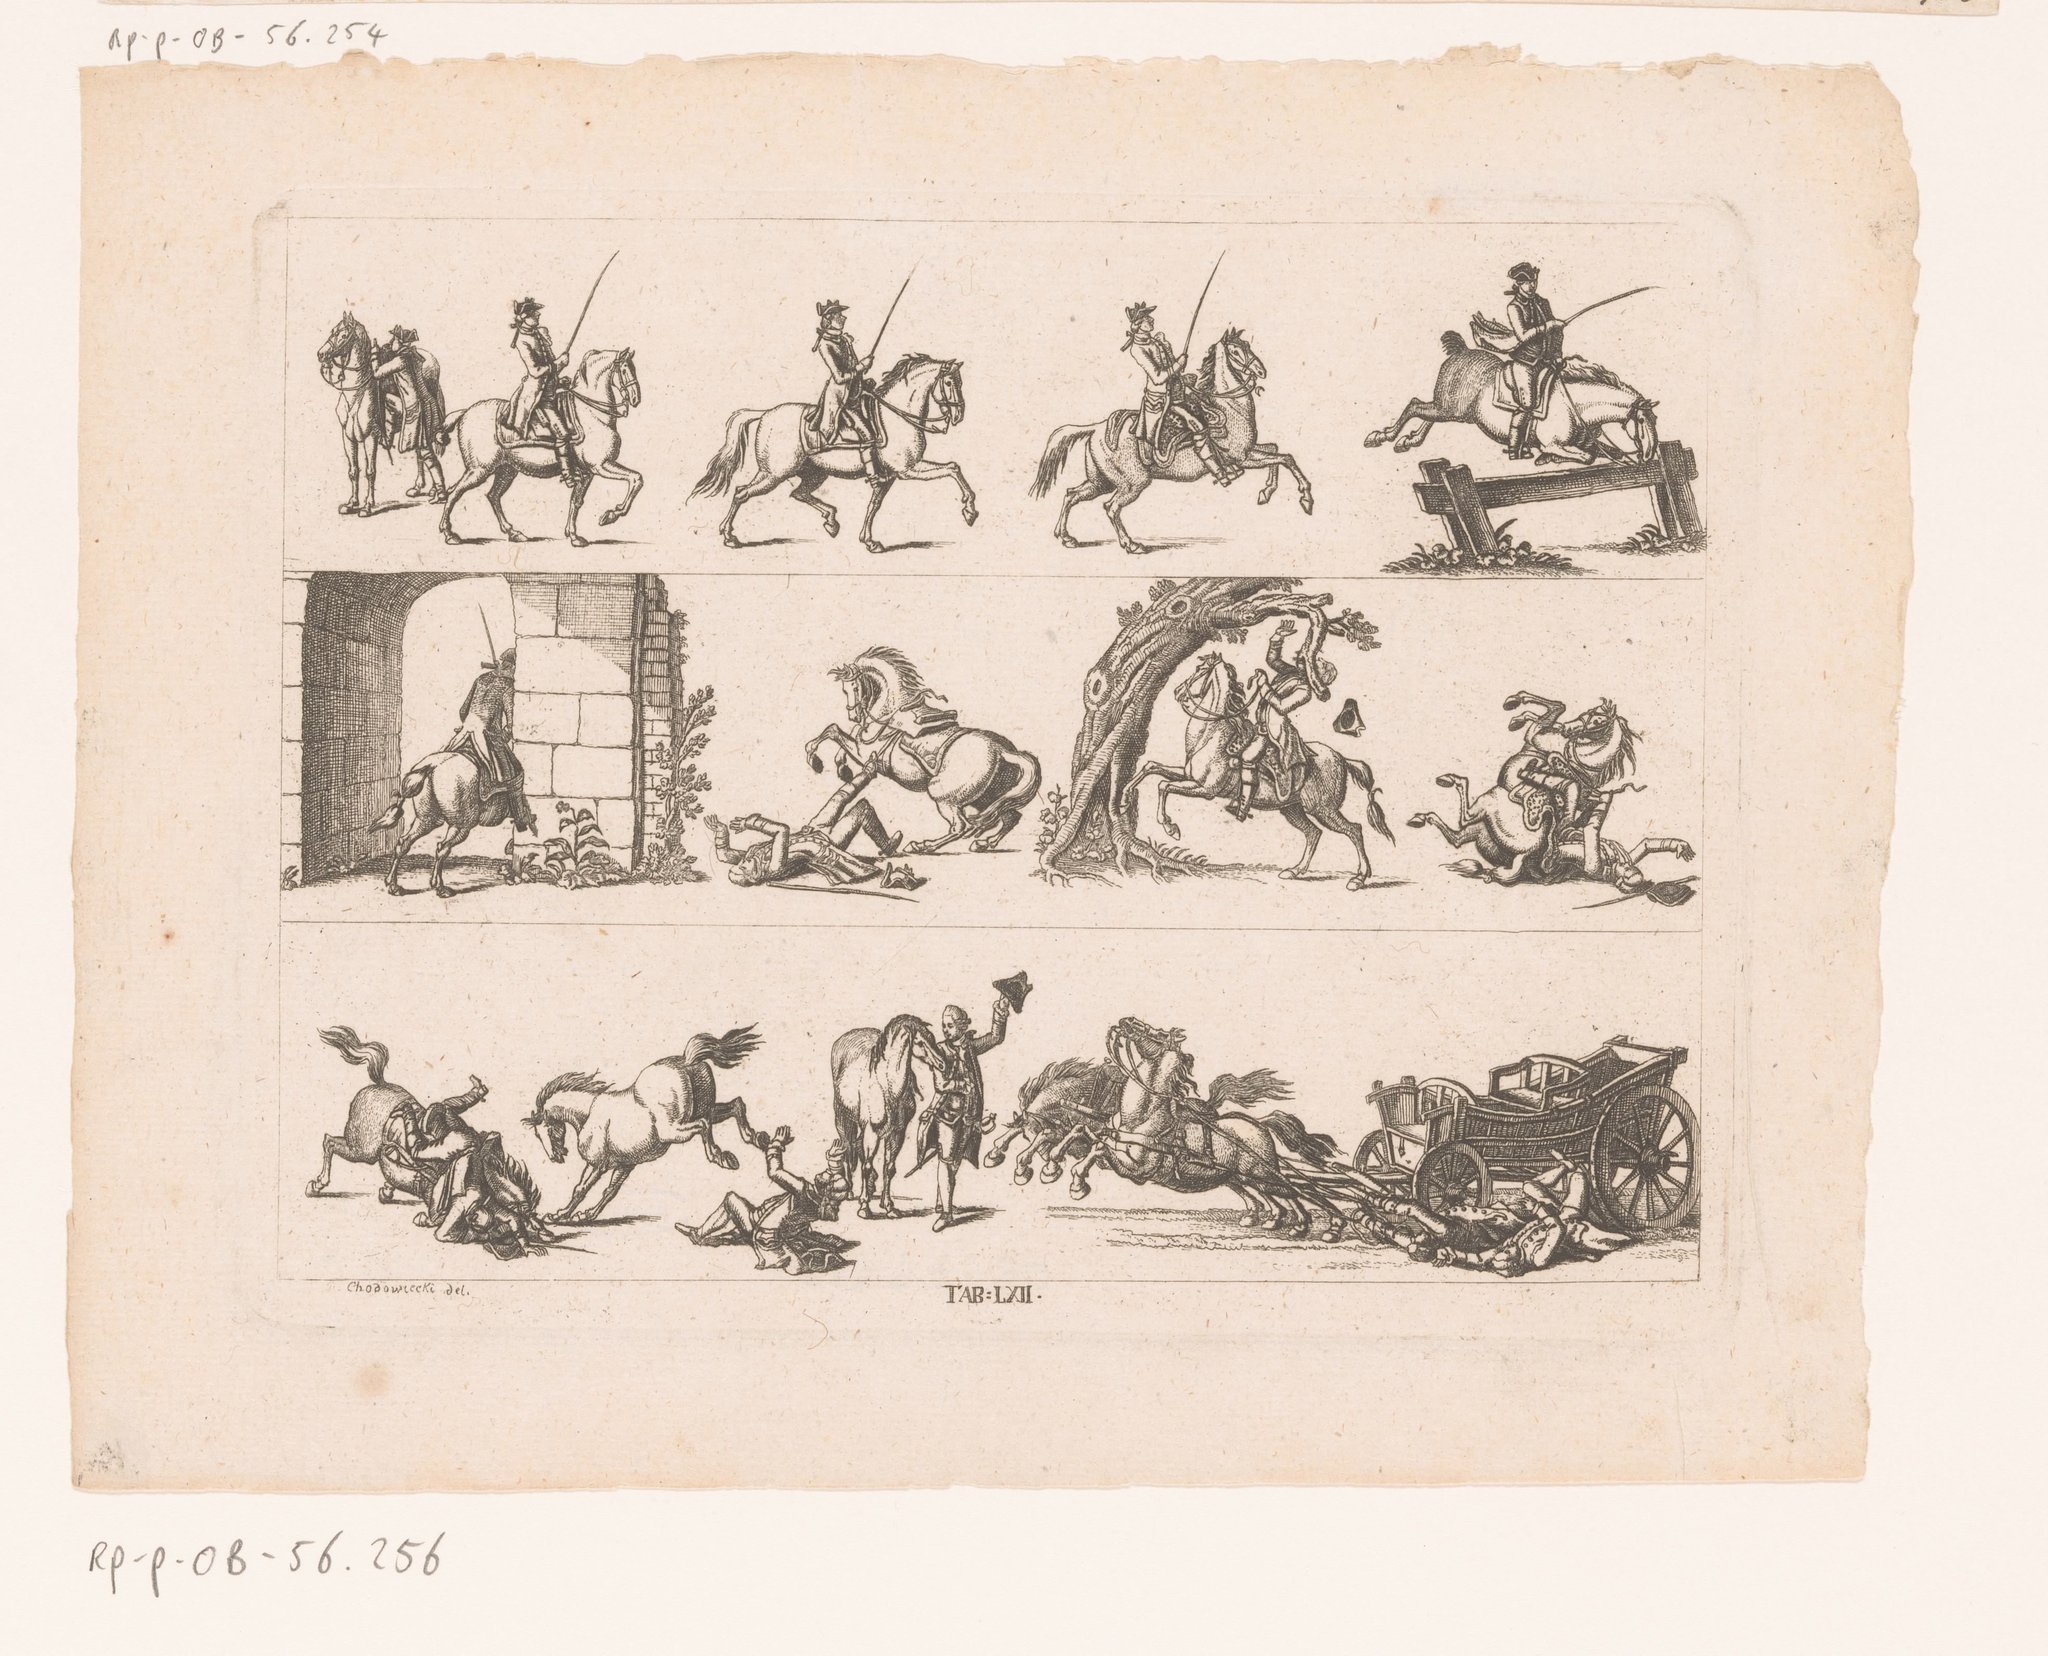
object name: print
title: Encyclopedische voorstelling van het gebruik van paarden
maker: Anonymous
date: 1774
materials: paper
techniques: etching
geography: germany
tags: johann bernhard basedow, accident with horse (or kindred animal)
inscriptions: collector's mark: Lugt 2228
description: De prent maakt onderdeel uit van een serie van 96 prenten die verschenen ter illustratie van het 'Elementarwerk' van de Duitse pedagoog Johann Bernhard Basedow. De prenten werden door verschillende kunstenaars vervaardigd naar tekeningen van Daniel Chodowiecki. In 1774 verscheen het verzamelde prentwerk bij Crusius in Leipzig onder de titel: Kupfersammlung zu J.B. Basedows Elementarwerk für die Jugend und ihre Freunde.